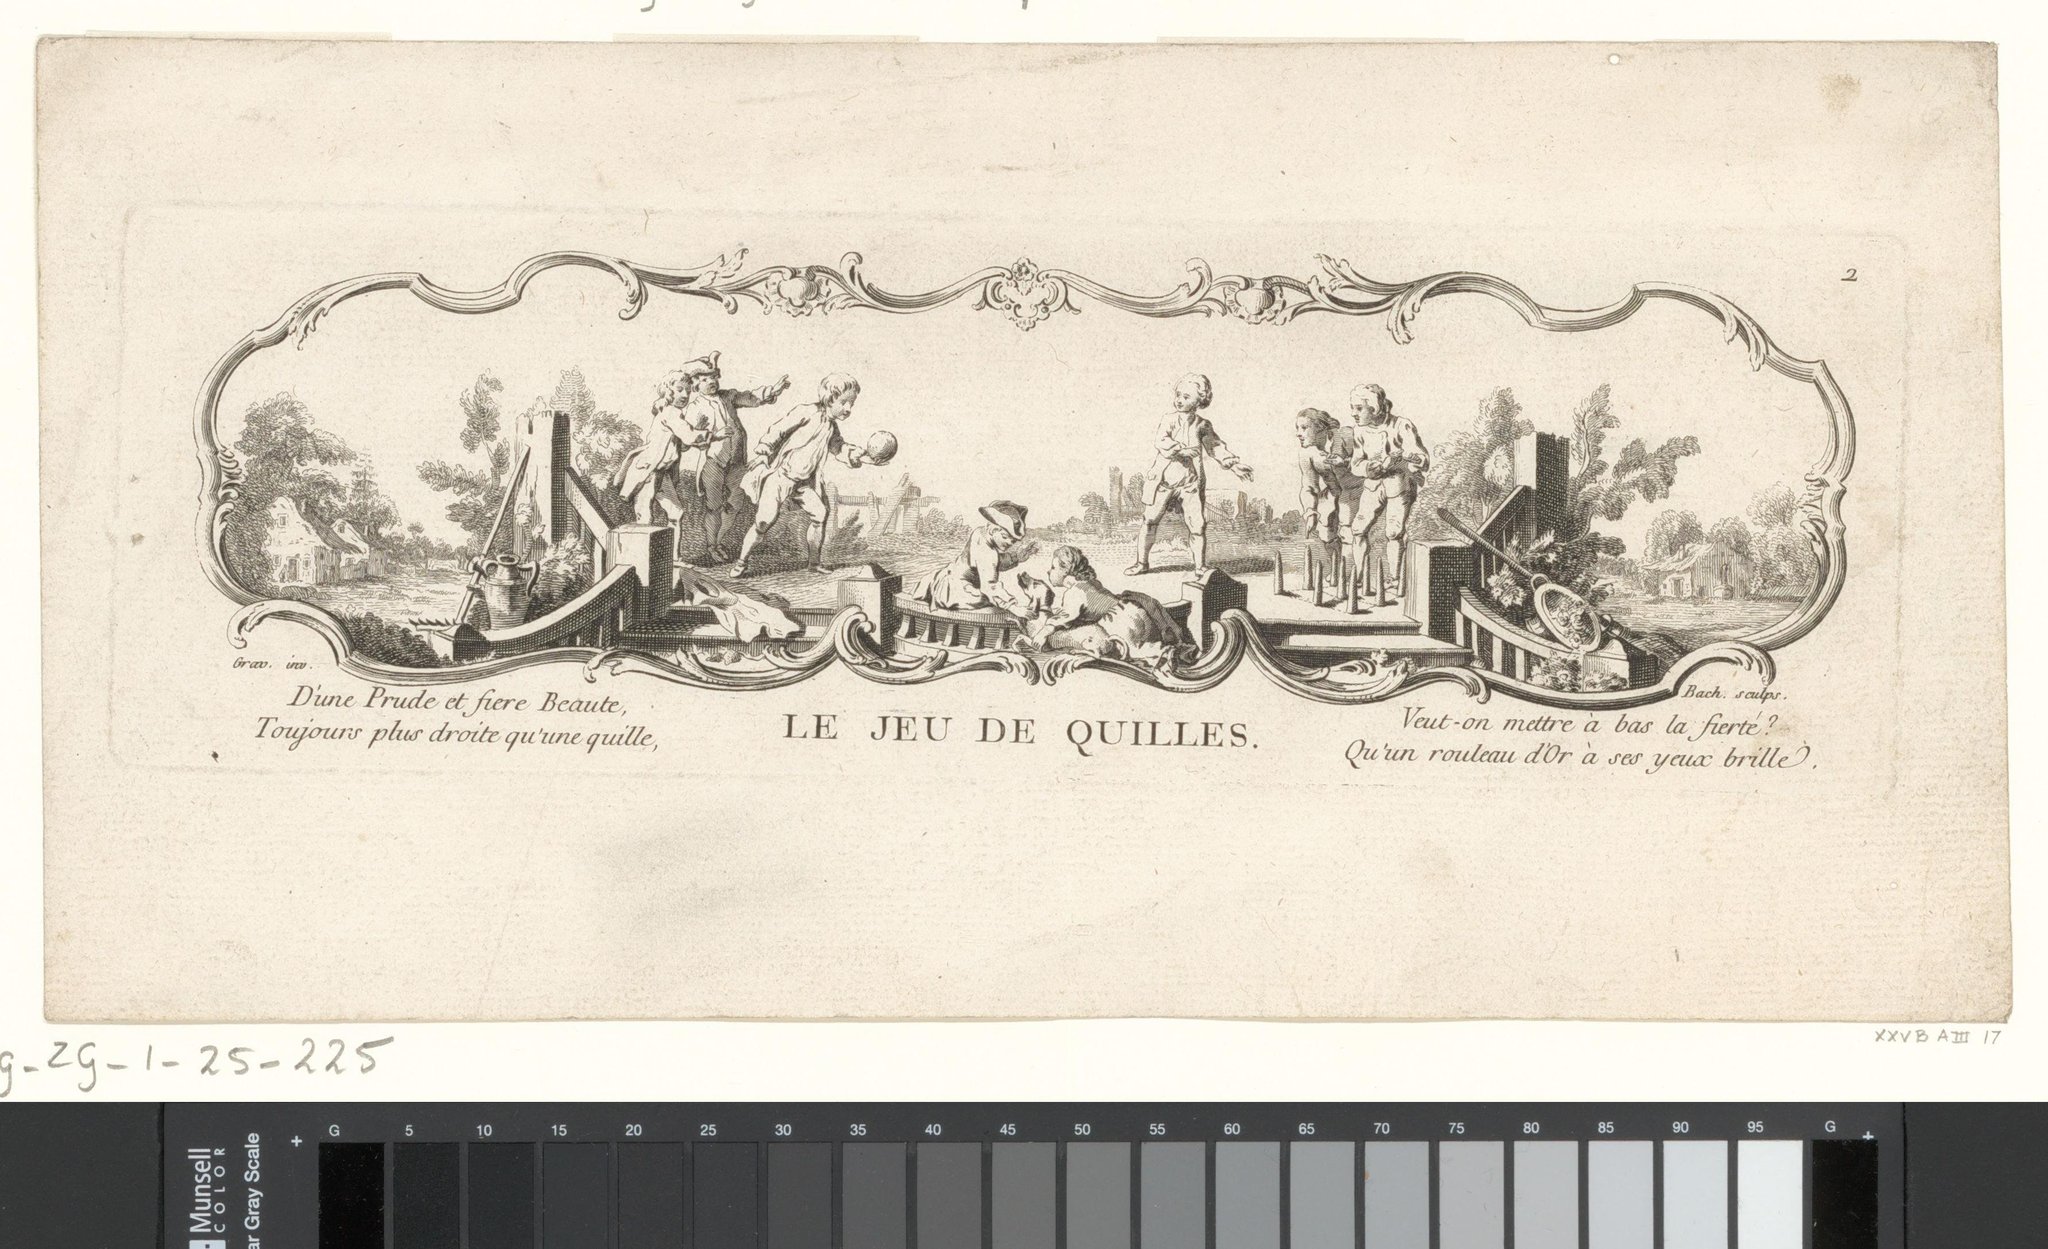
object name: print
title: Kegelende kinderen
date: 1722-1781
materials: paper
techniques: engraving, etching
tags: children's games and plays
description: Onderaan een vierregelig vers. Rechtsboven genummerd: 2. Onderwerpsrubrieken binnen de Atlas Zeden en Gewoonten: Zeden en Gewoonten in Engeren Zin, Spel en vermaak, Oud-Hollandsch volksspel, Kegelen.